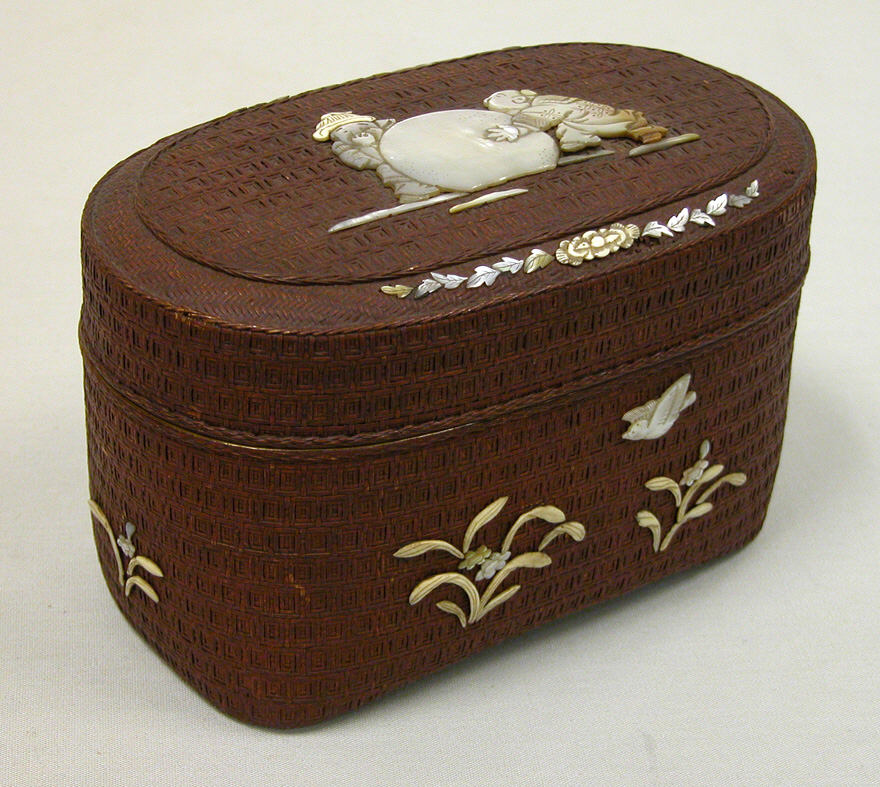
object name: box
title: Basket Box with Design of Two Chinese Children and Snowball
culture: japanese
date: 1801-1900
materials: ivory, mother of pearl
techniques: lacquer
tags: boys,snow